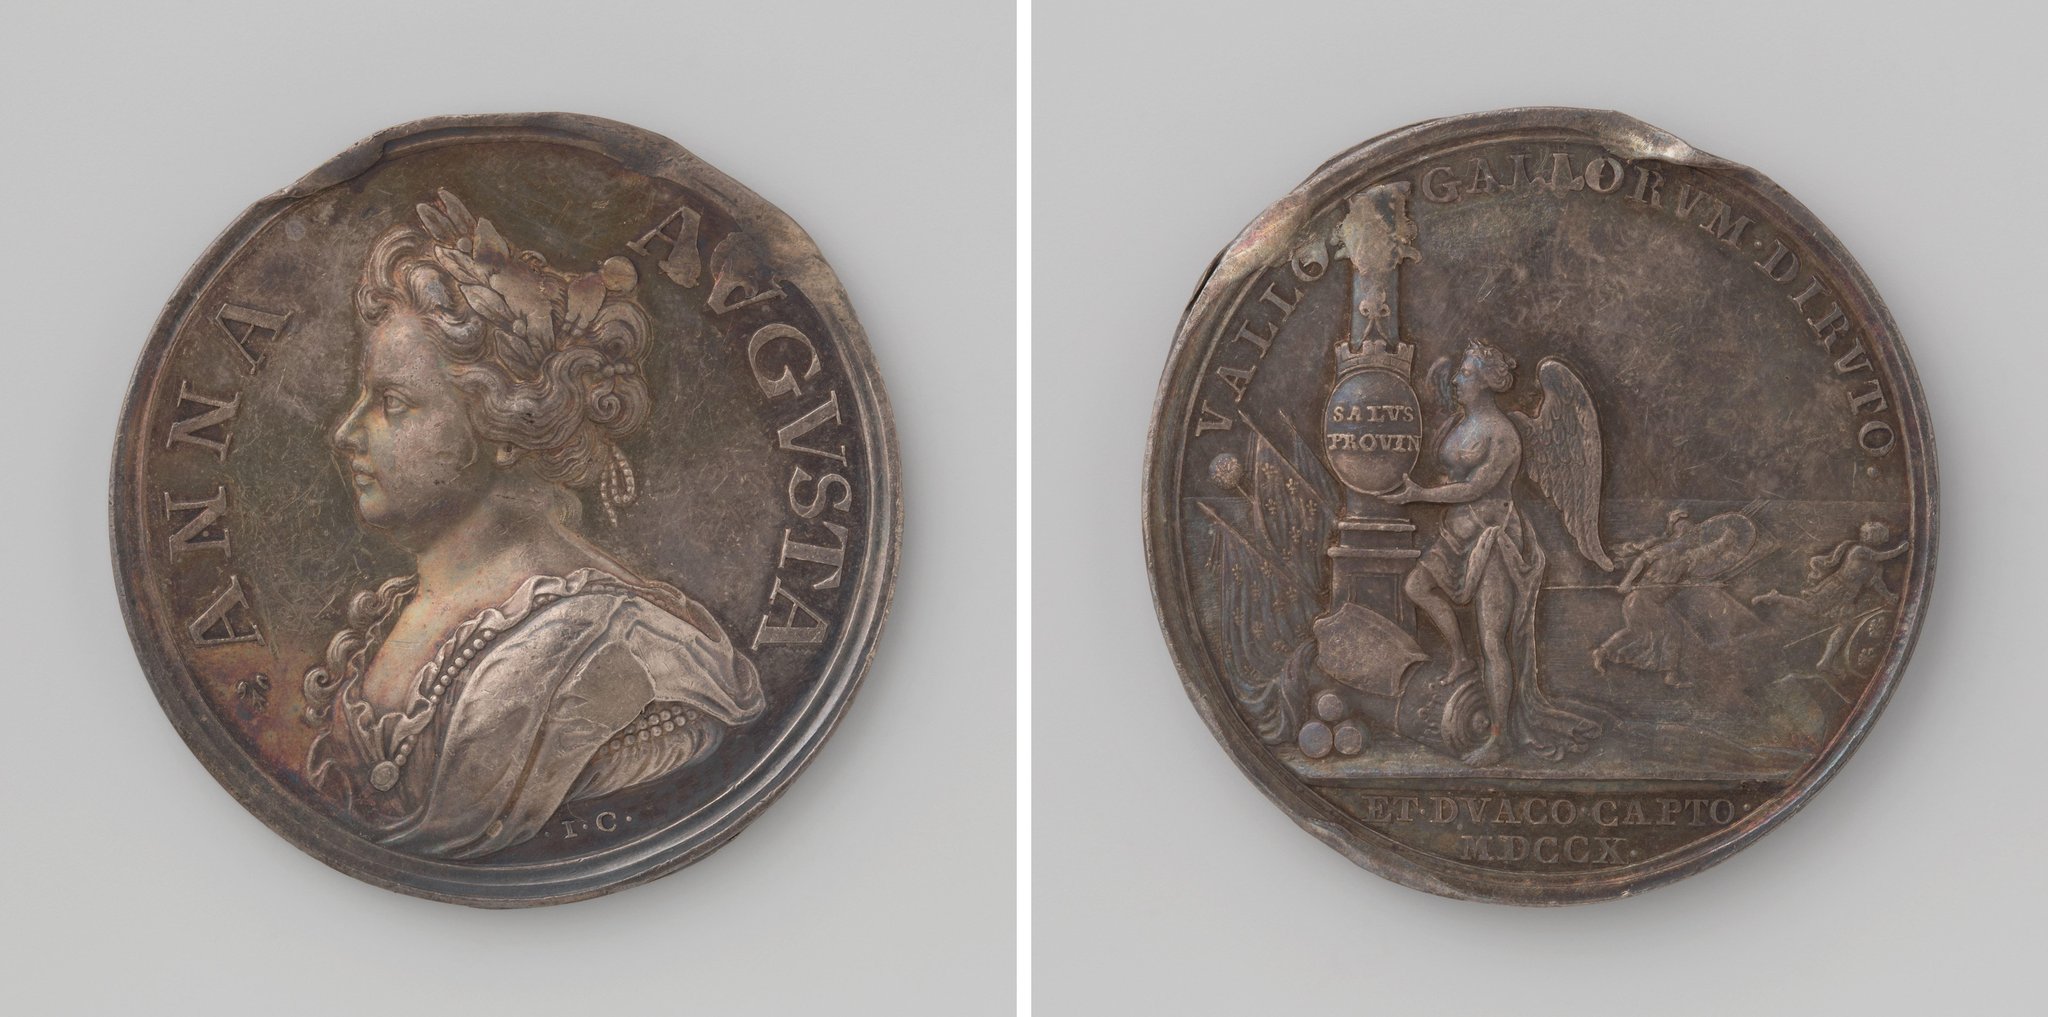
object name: history medal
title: Inname van Douai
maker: john croker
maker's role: die cutter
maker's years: 1670-1741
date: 1710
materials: silver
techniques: striking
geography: london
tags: london, anna stuart (koningin van engeland en schotland)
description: Zilveren penning. Voorzijde: borststuk vrouw met lauwerkrans binnen omschrift. Keerzijde: gevleugelde Overwinning staande met voet op stapel Frans wapentuig en vaandels bevestigt gekroond wapenschild aan pilaar, op achtergrond verjaagt Bellona Frans soldaat binnen omschrift; afsnede: opschrift.